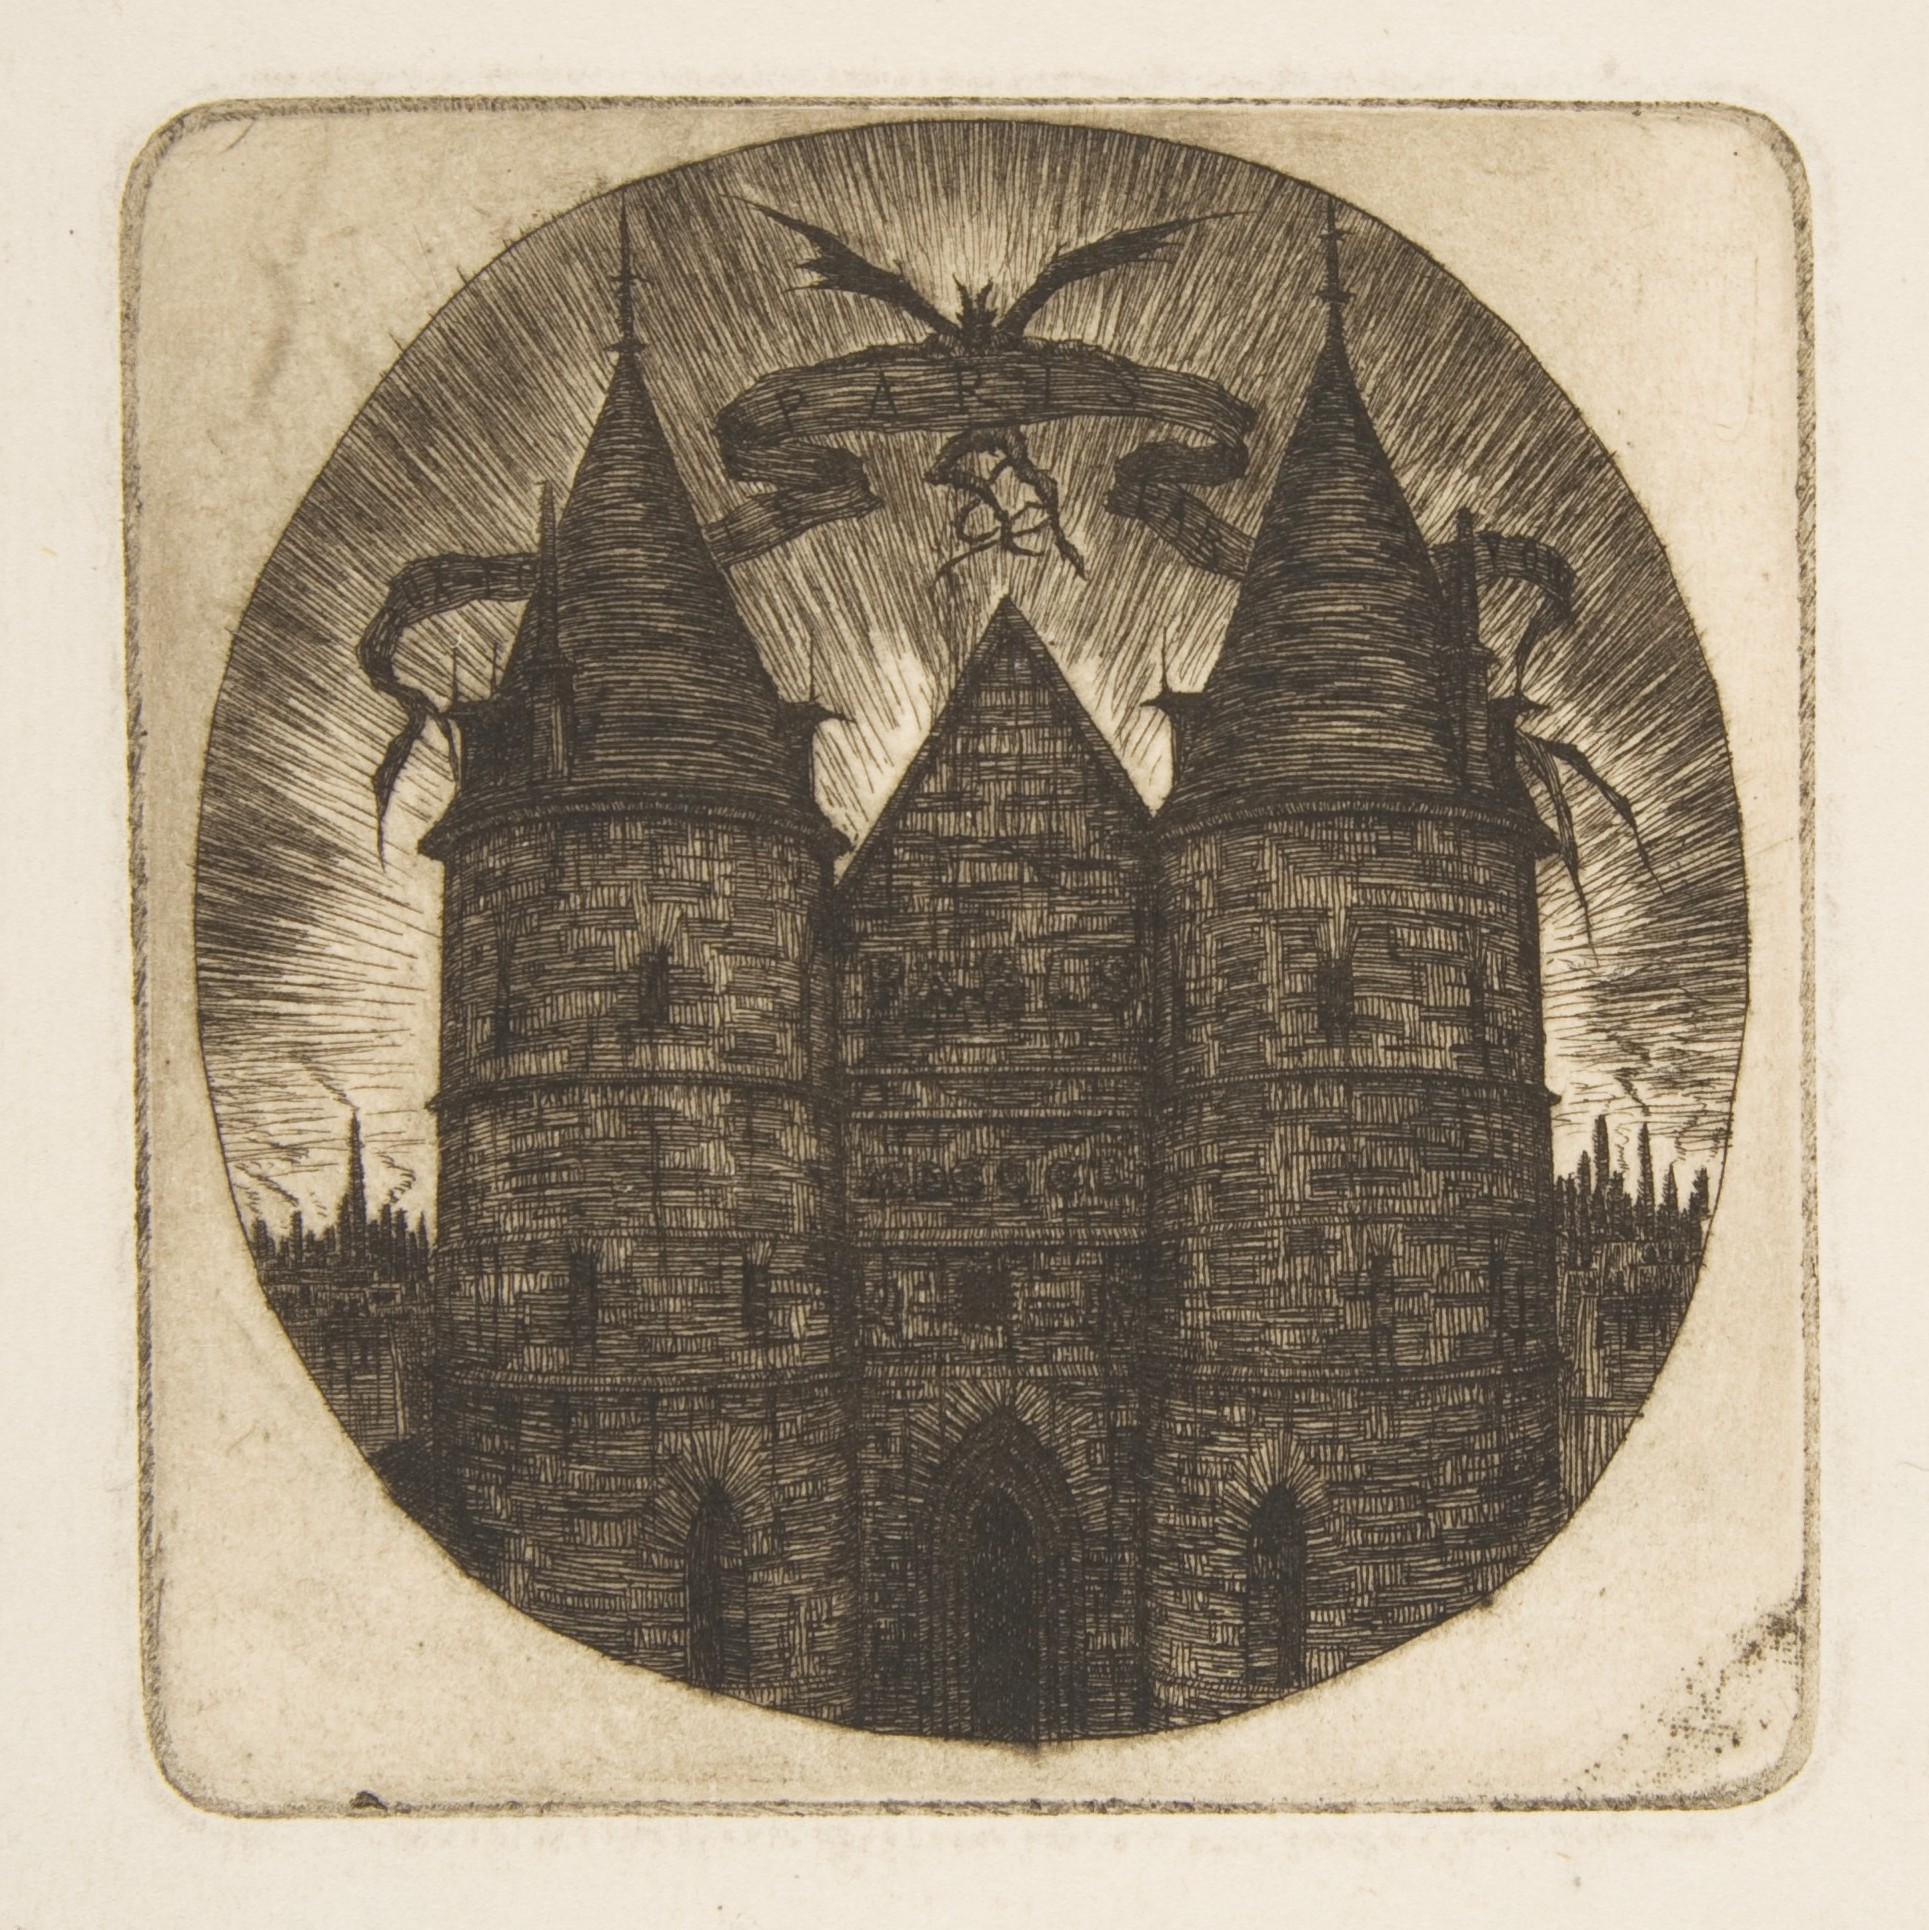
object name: print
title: The Old Gate of the Palais de Justice, Paris, frontispiece to "Etchings of Paris"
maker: charles meryon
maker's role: artist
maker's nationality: french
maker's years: 1821-1868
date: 1854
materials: paper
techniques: drypoint, etching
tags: buildings,gates,paris